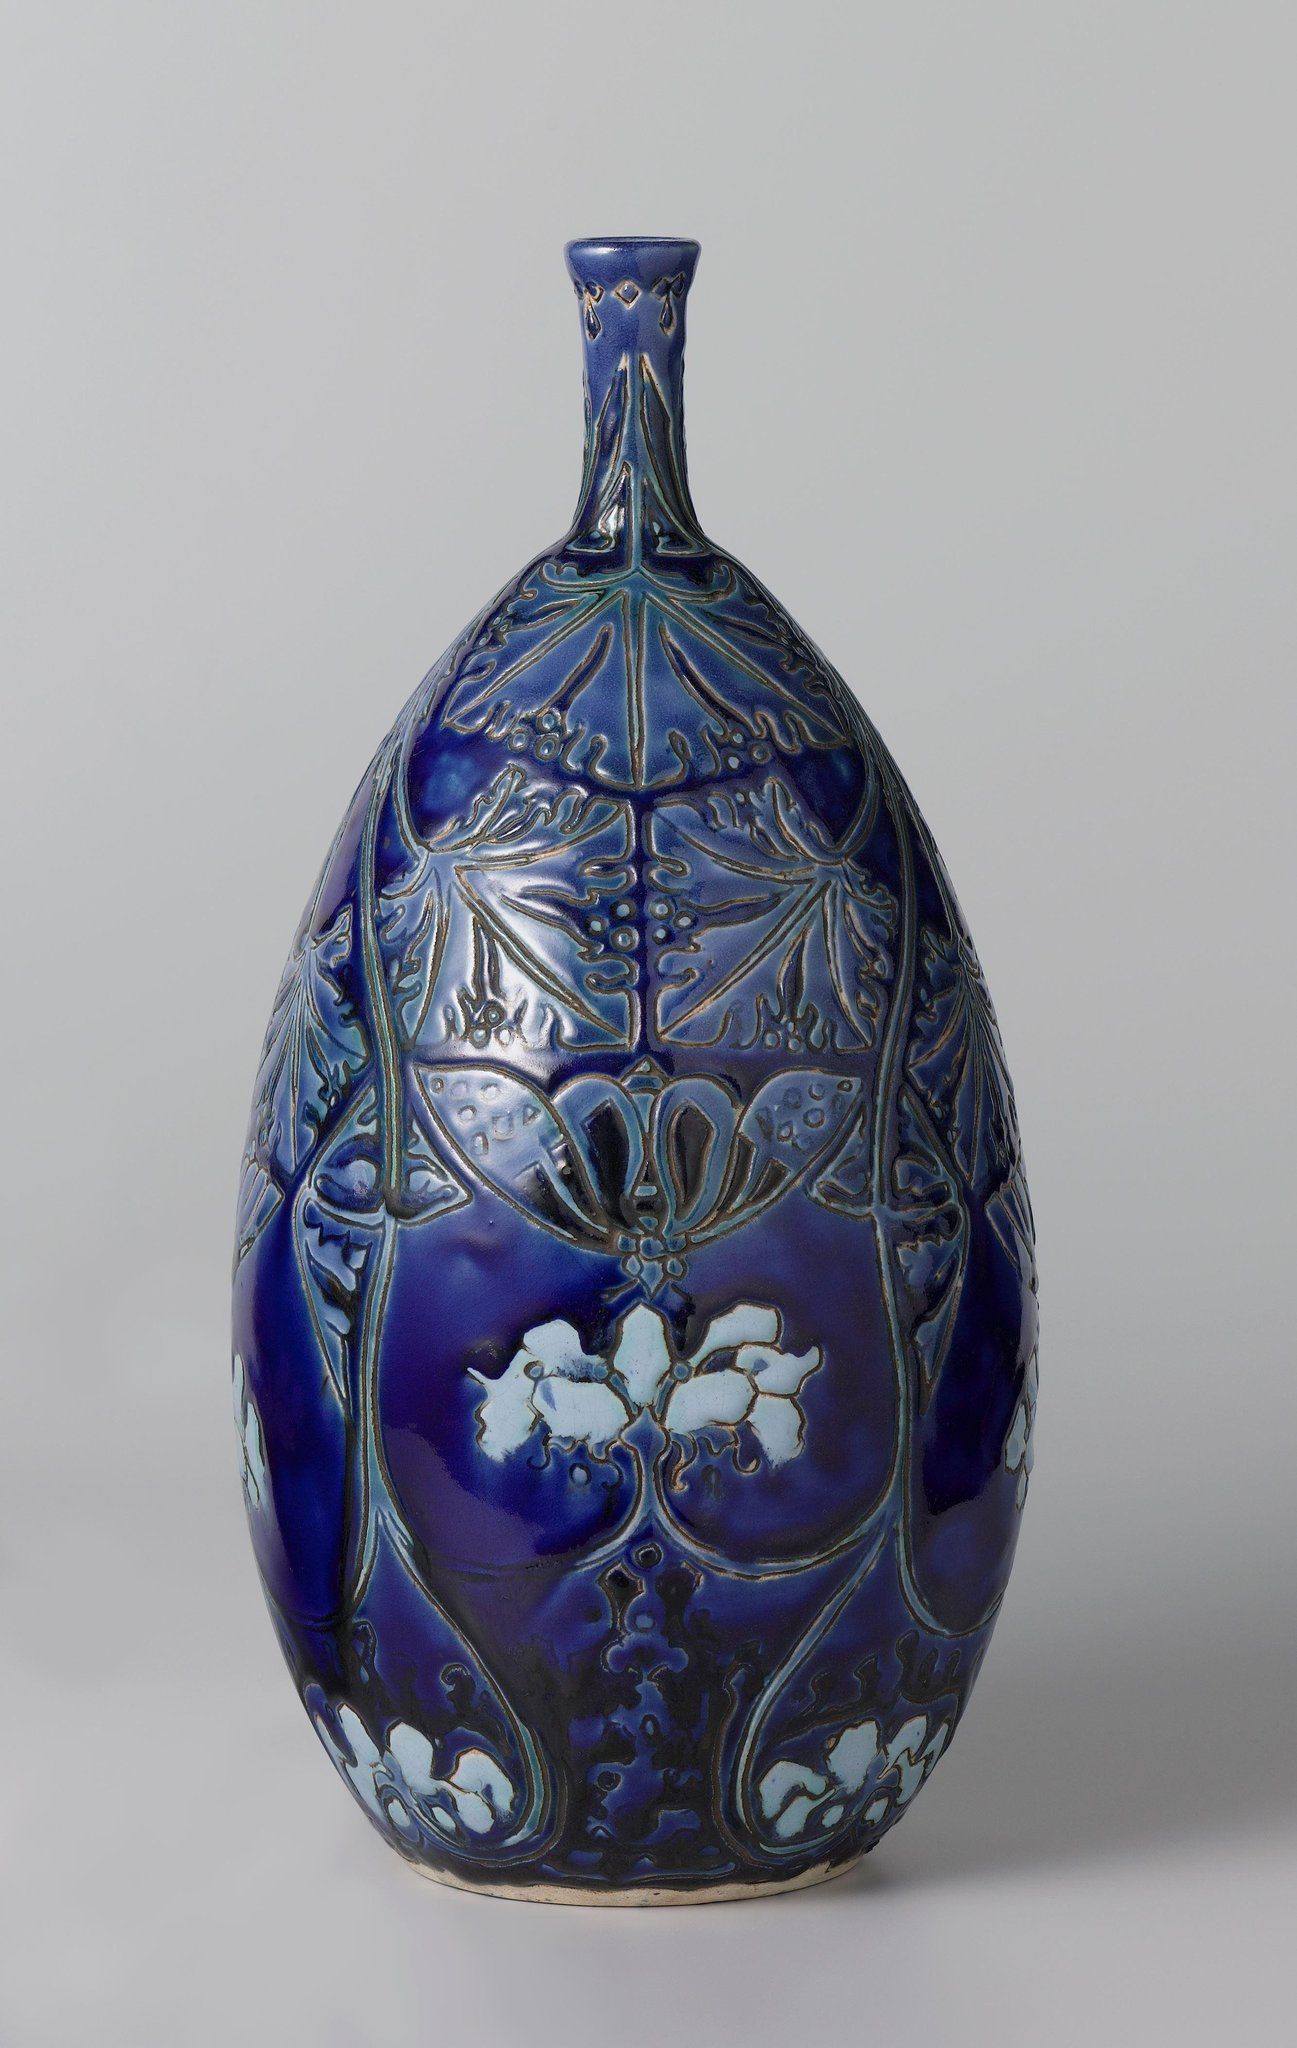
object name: vase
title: Vaas, versierd met bloemen, bladeren en vlinders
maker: theo nieuwenhuis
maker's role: designer, draughtsman, print maker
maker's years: 1866-1951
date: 1915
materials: earthenware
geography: amsterdam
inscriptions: mark: ‘DISTEL; fecit Th.N; in zwart: No C2081 f40,-’, label: ‘nr. 301 f40,-’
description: Two vases. Earthenware decorated in the cuerda seca-technique, known as carduus earthenware. Amsterdam, c. 1915, made by Plateelbakkerij De Distel, designed by Theodorus W. Nieuwenhuis, factory under the direction of J.M. Lob.